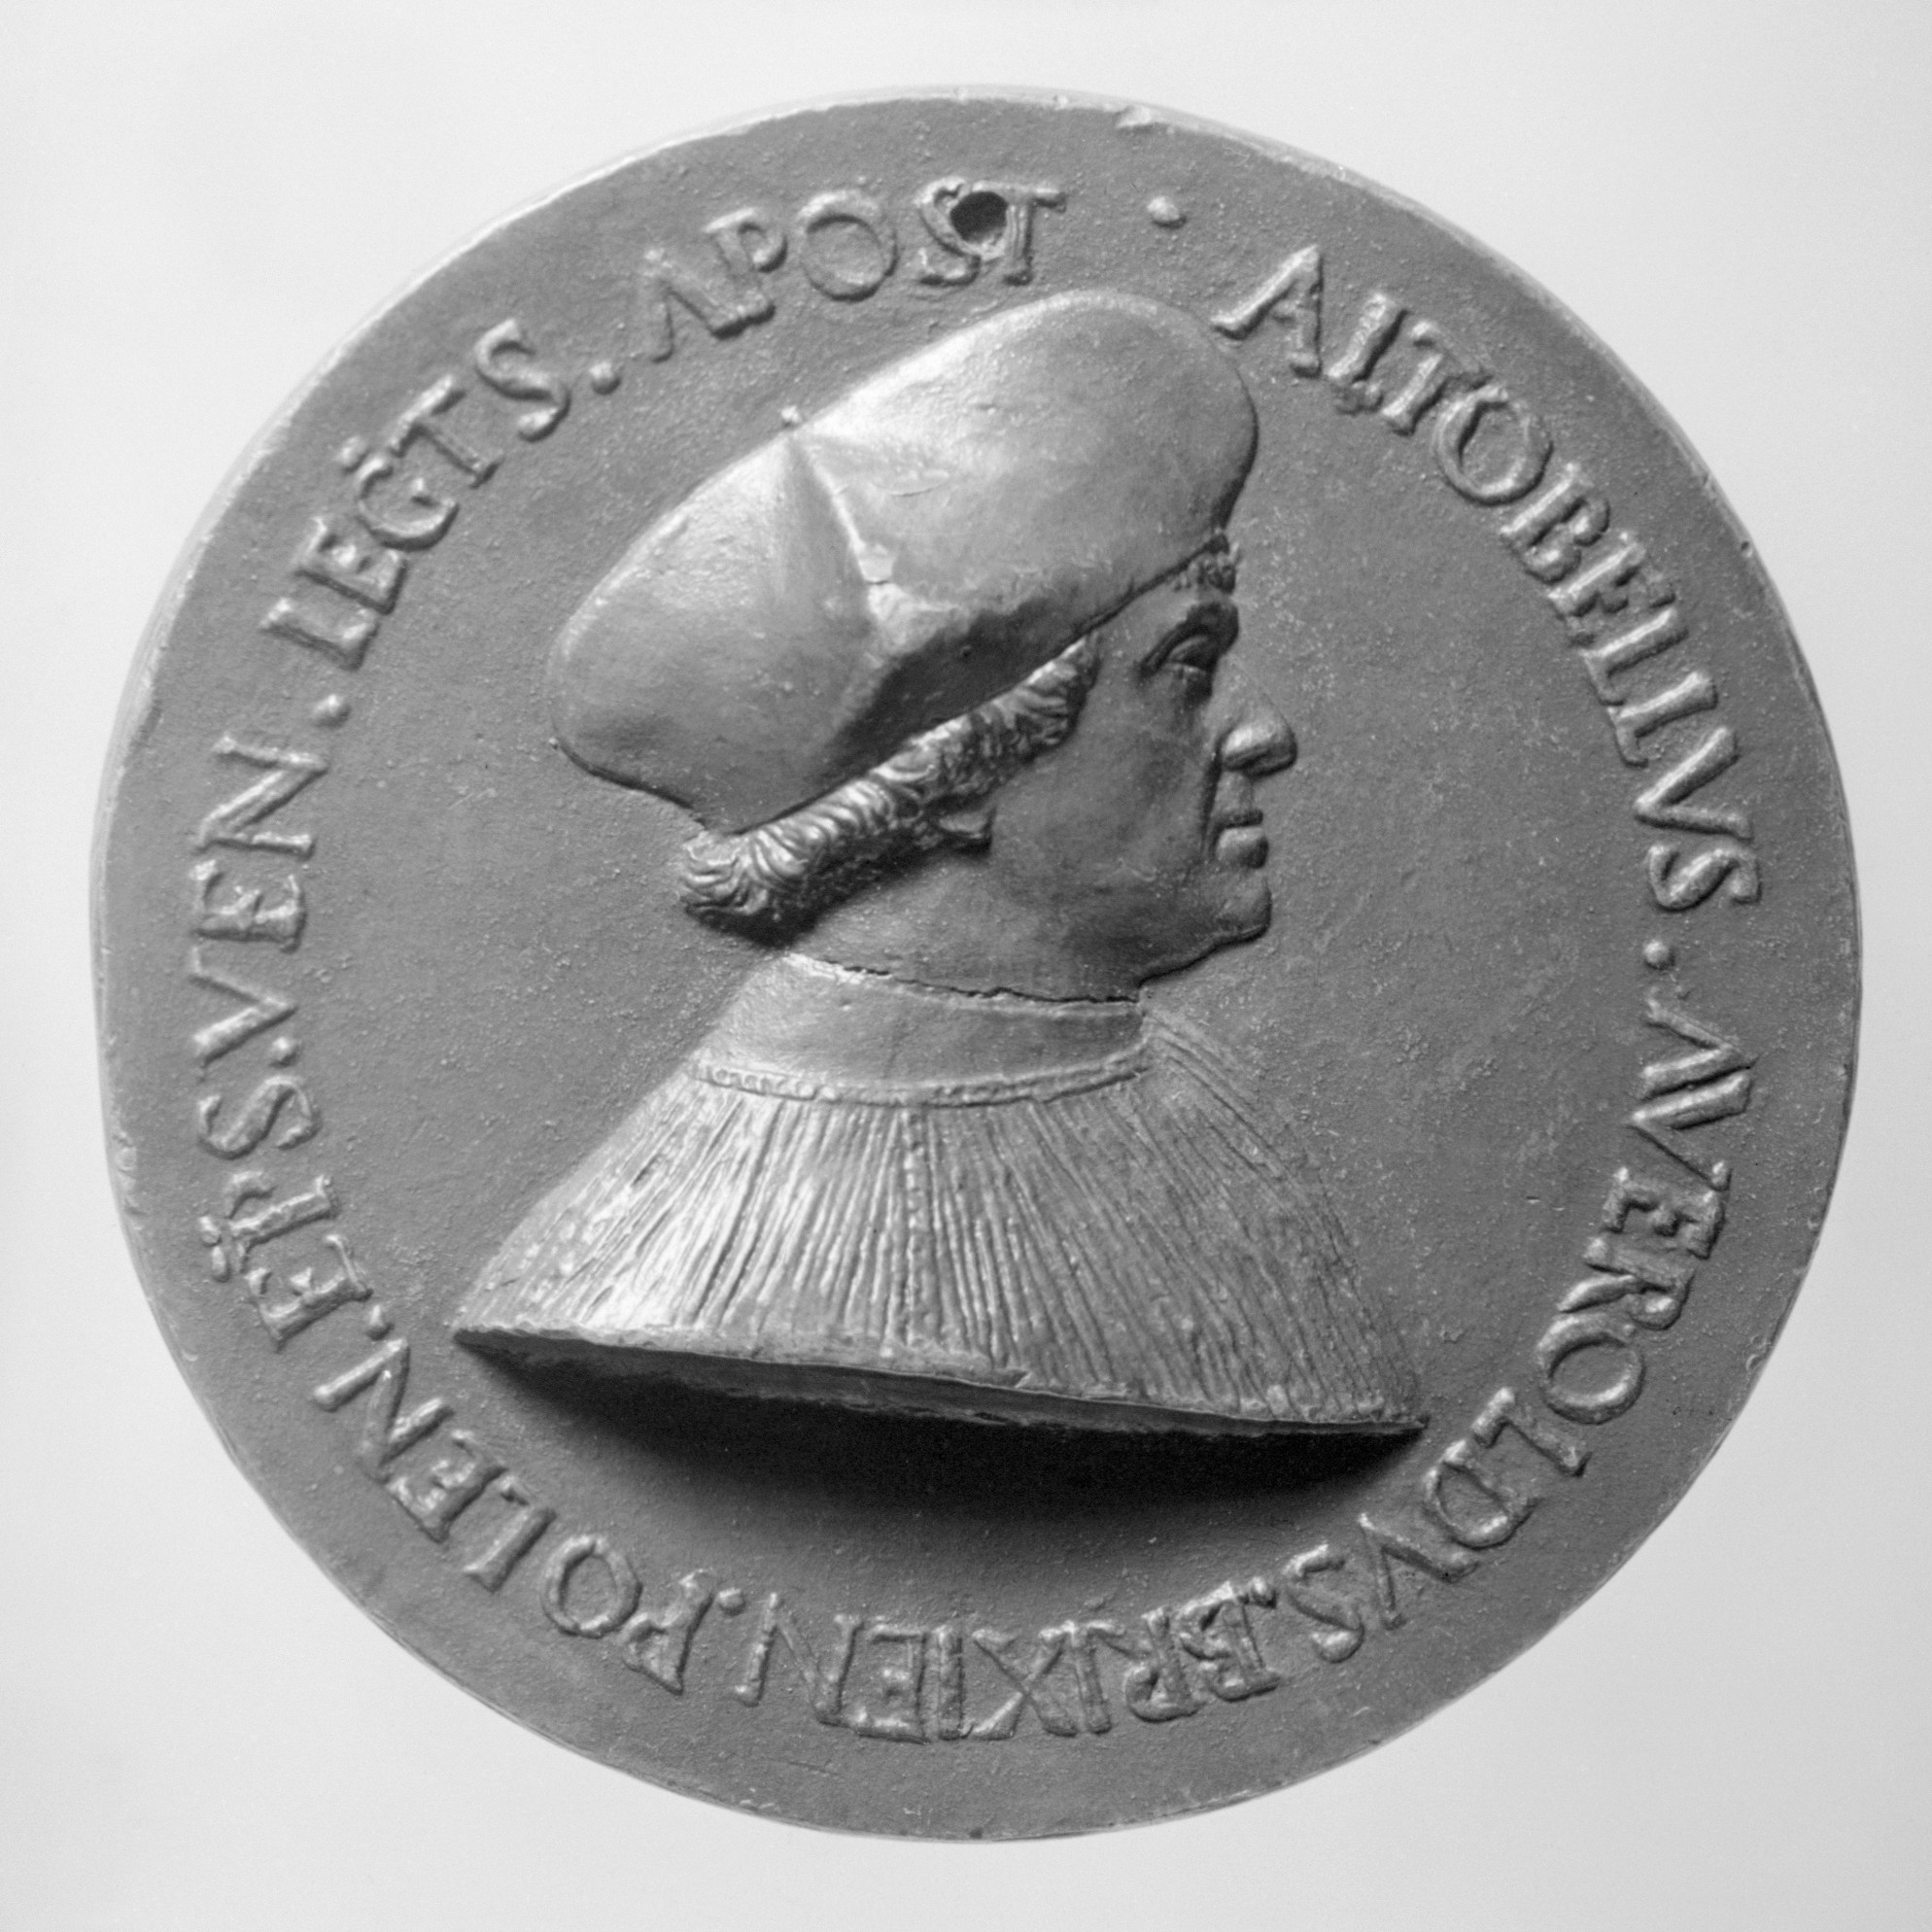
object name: medal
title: Altobello Averoldo of Brescia, Bishop of Pola (1497–1532)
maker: maffeo olivieri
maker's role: artist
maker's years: 1484-1544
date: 1501-1550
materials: lead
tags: profiles,bishops